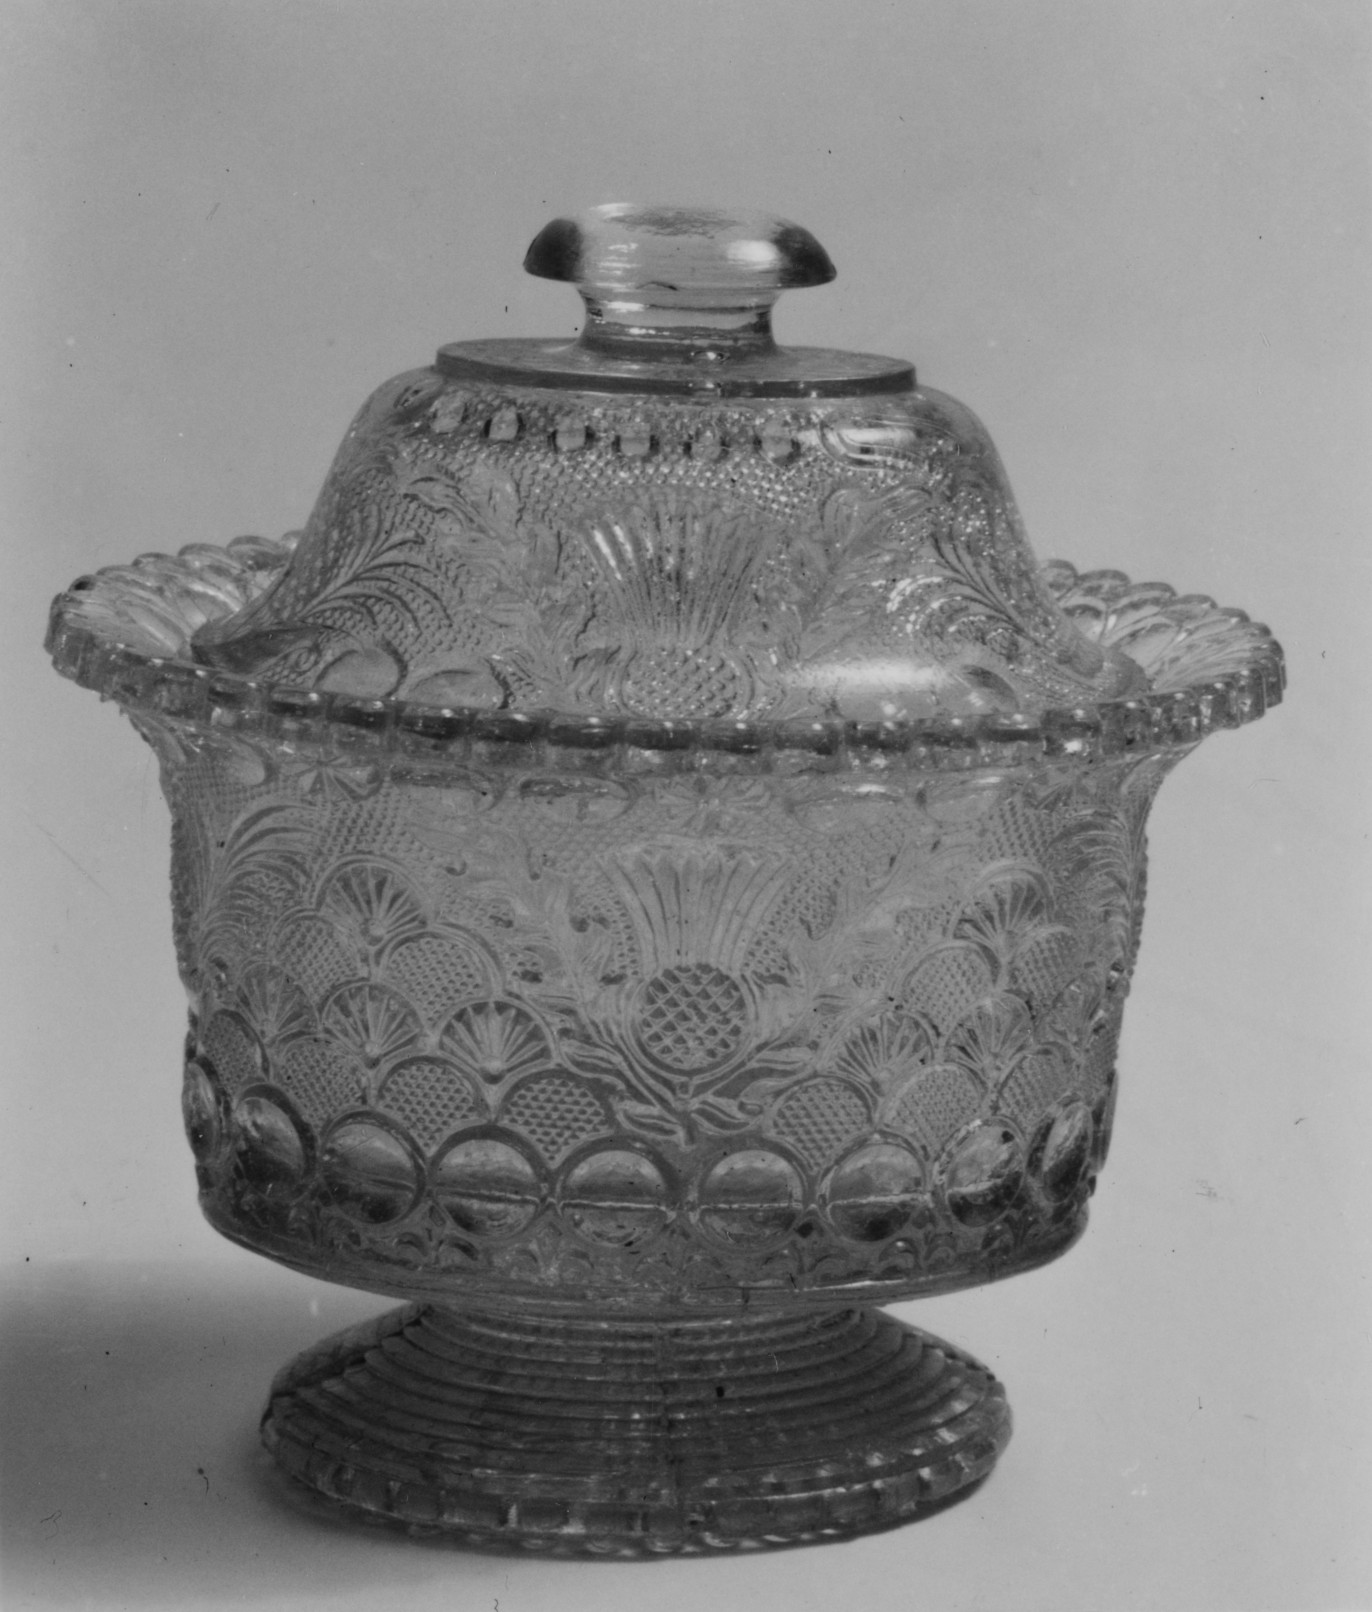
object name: sugar bowl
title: Covered Sugar Bowl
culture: american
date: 1835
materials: glass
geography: united states